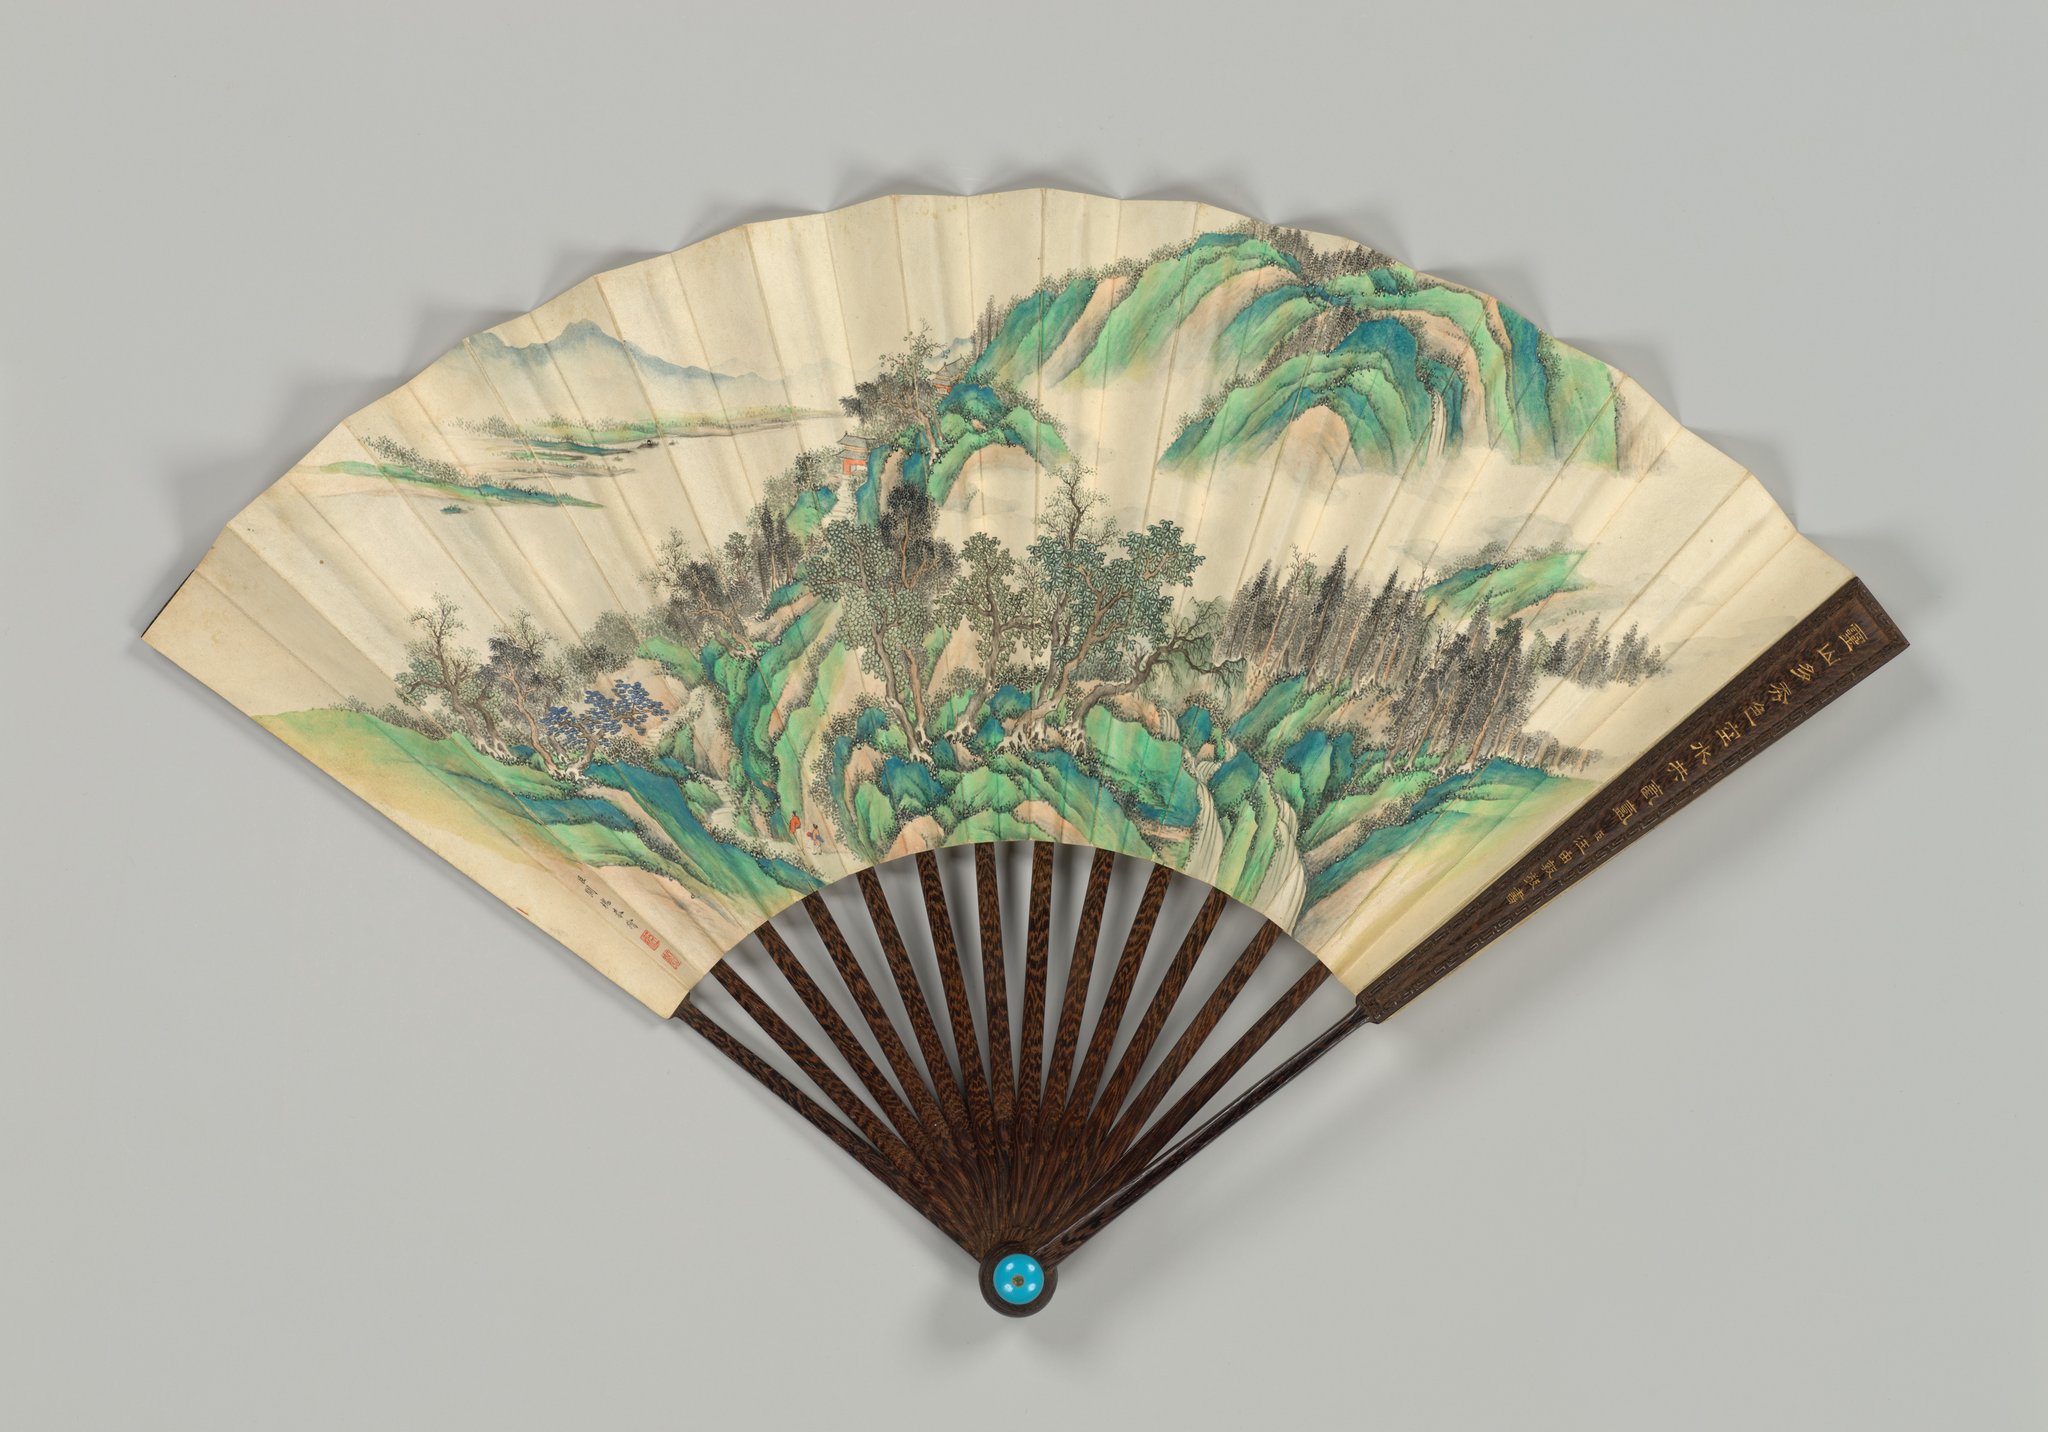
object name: fan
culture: chinese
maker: unidentified artist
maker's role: artist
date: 1736-1795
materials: paper